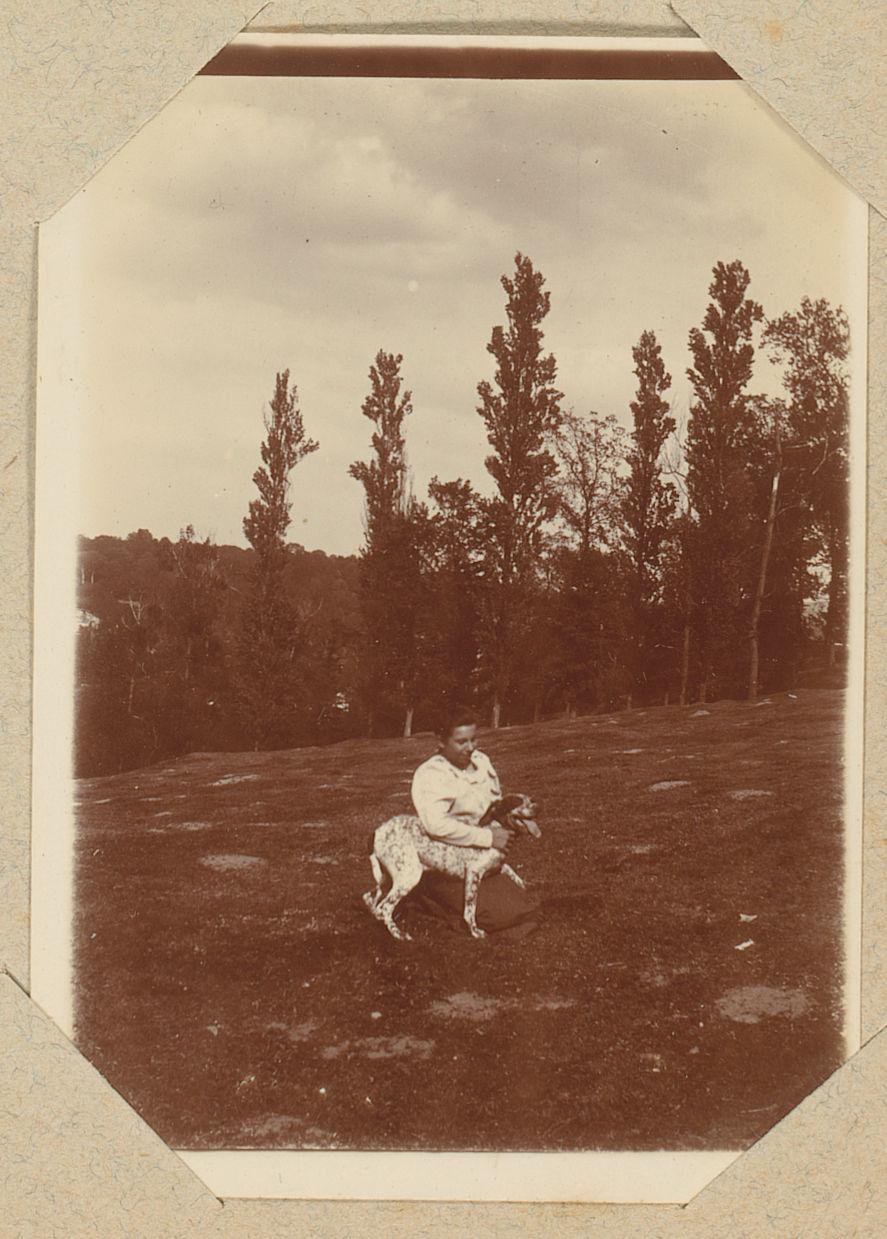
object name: photograph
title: Vrouw met een hond in een veld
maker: Anonymous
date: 1897-1900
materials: paper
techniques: gelatin silver print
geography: france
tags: adult woman, dog, france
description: Over de foto is een ander negatief afgedrukt van een voorstelling van bomen.